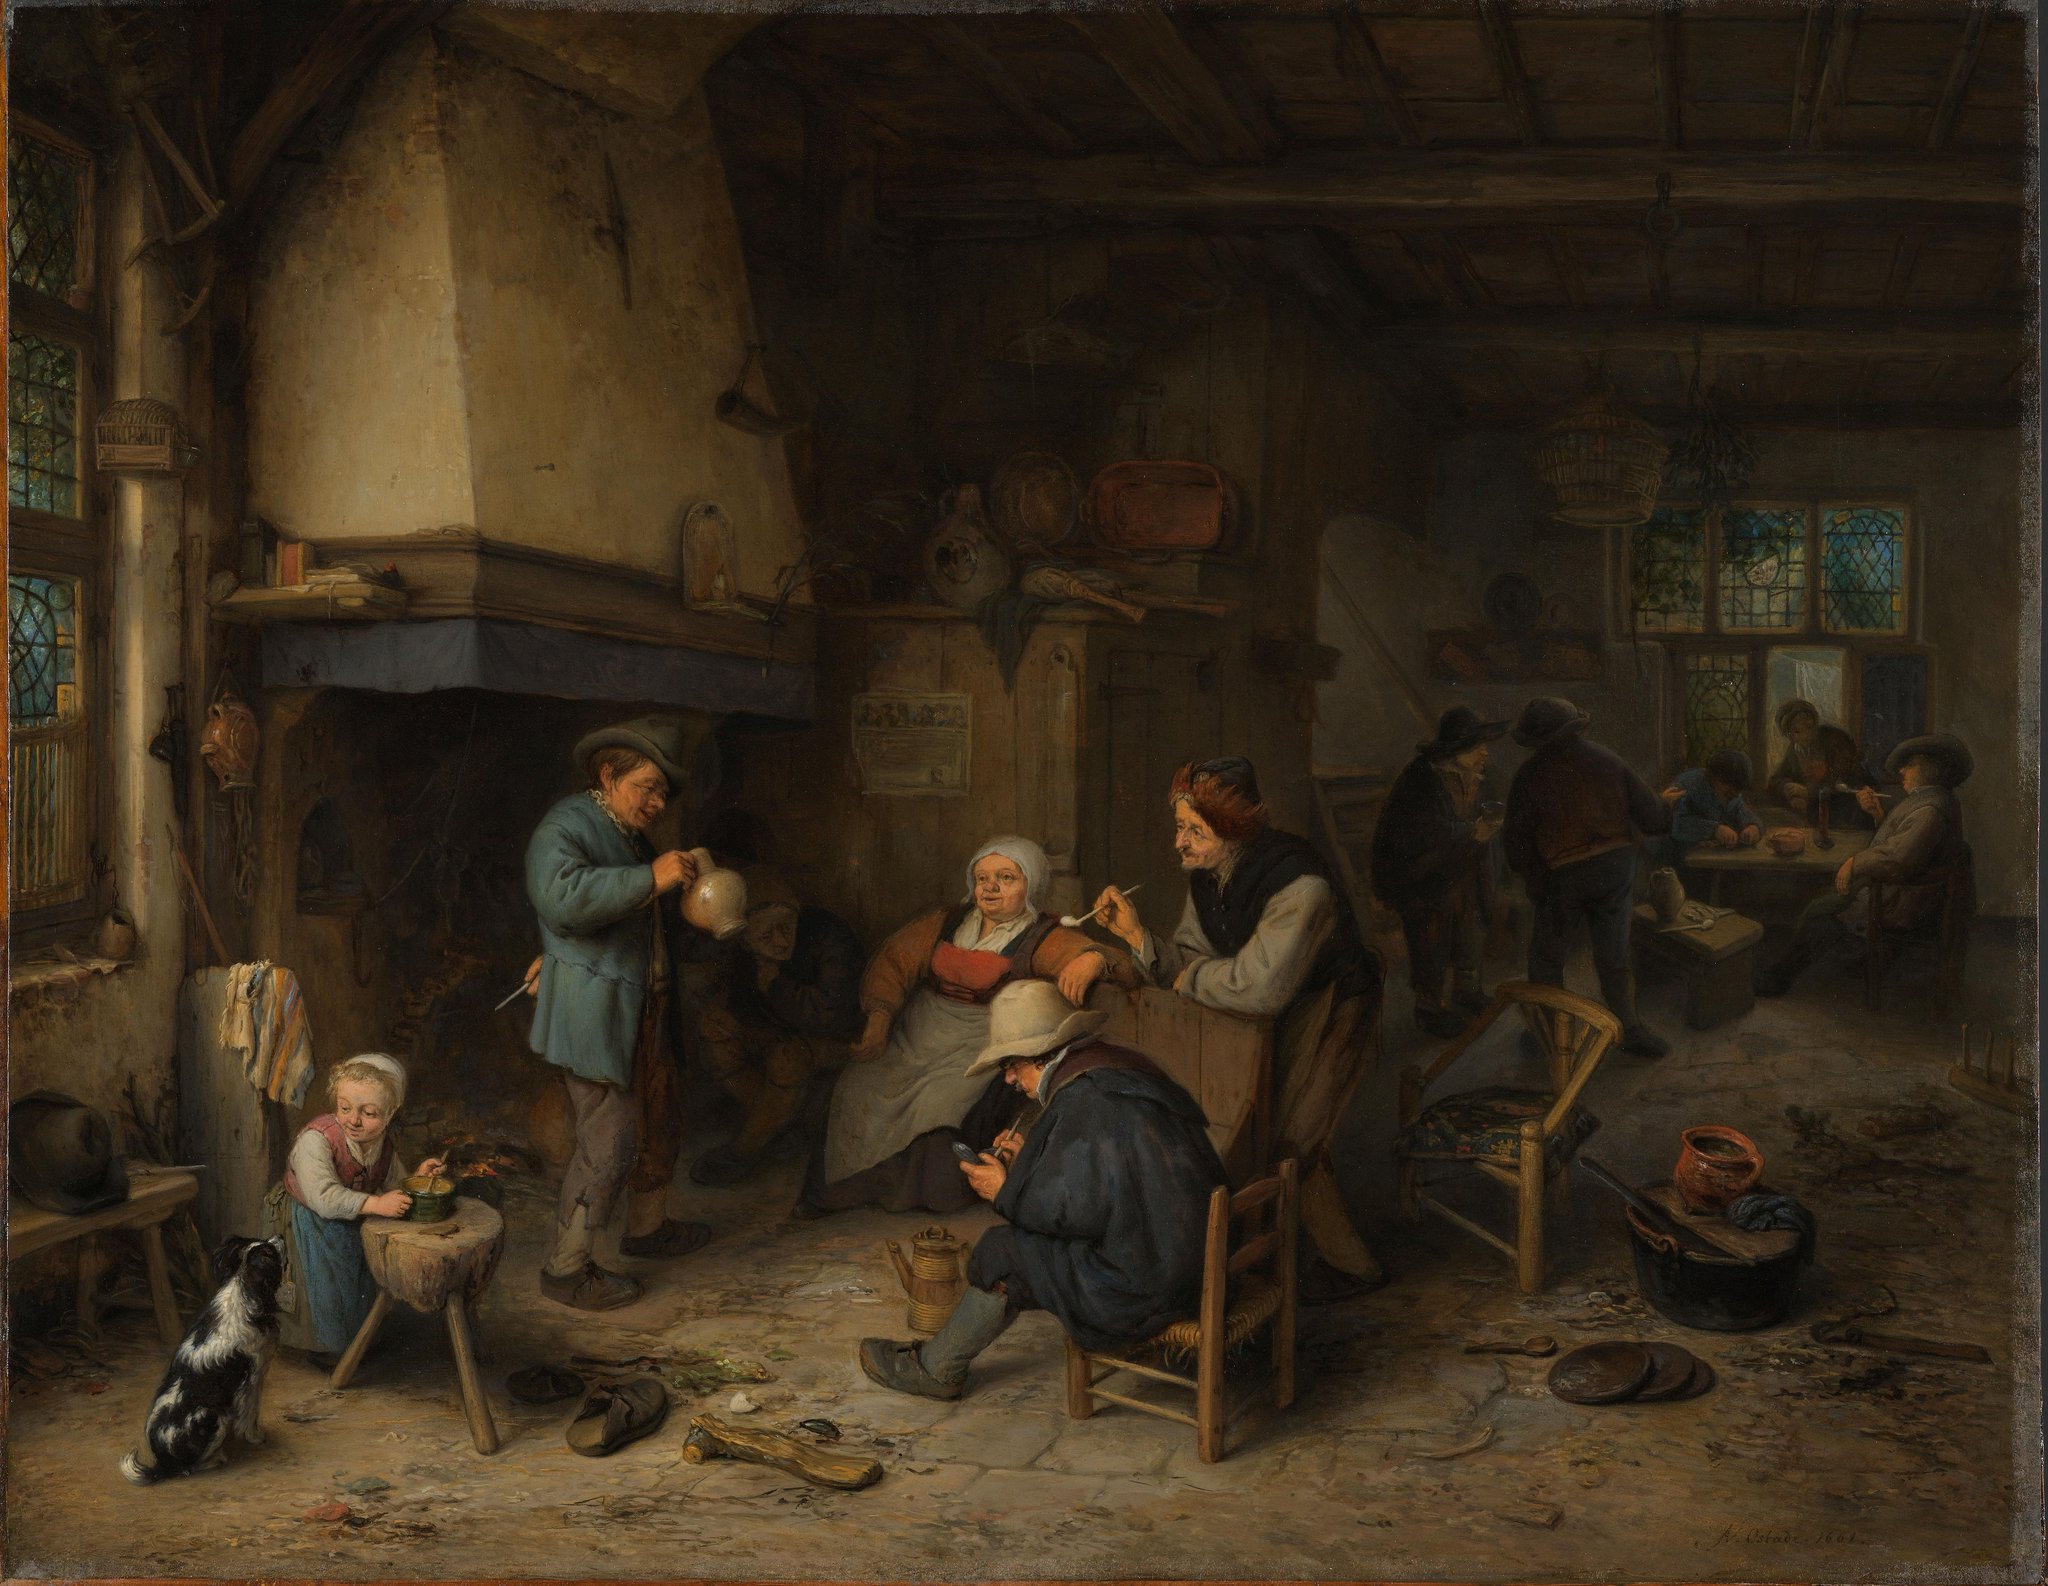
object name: painting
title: Peasants in an Interior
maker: adriaen van ostade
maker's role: draughtsman, painter, print maker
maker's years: 1610-1685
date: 1661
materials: copper, oil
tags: inn, coffee-house, public house, etc., pipe ~ tobacco, jar, jug (used as drinking-vessel), open hearth, fire-place, farmers, dog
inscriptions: signature and date, bottom right: ‘Av. Ostade . 1661’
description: Three men and a woman discuss daily matters, and a child eats soup or porridge while a dog looks on. Peasant life does not seem at all bad. In Van Ostade’s early works, peasants regularly tumble over one another brawling, but in his later paintings, like this one, they are usually calmer and much more collected.